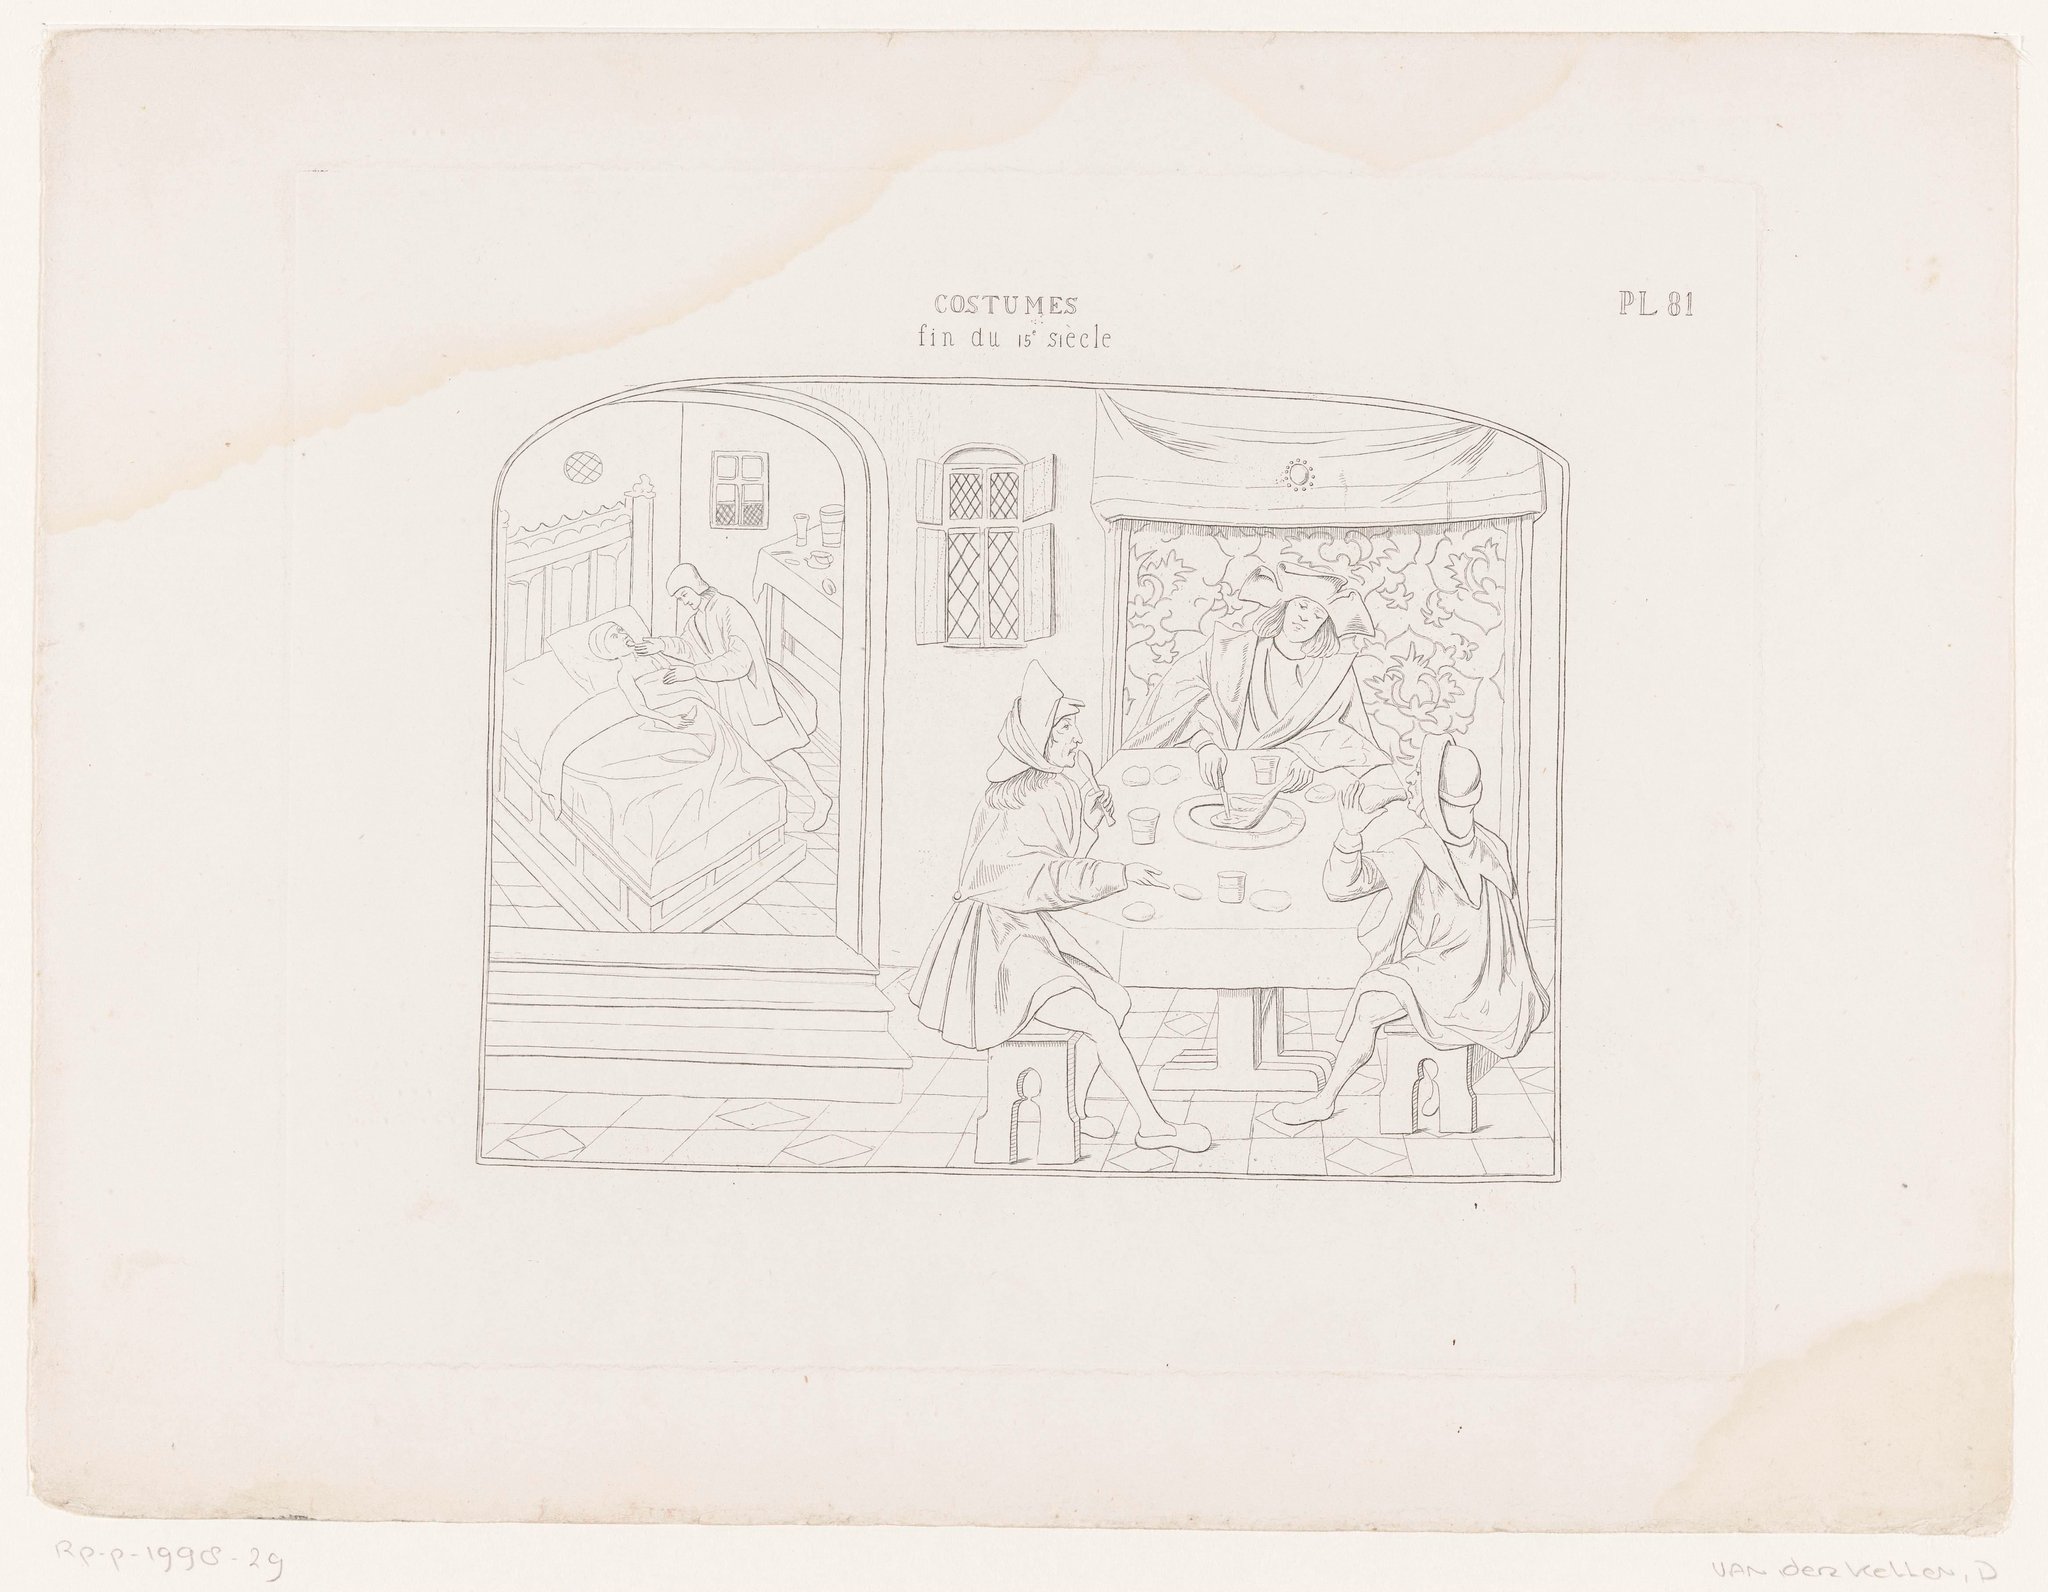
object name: print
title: Kostuums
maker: david van der kellen (1804-1879)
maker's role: die cutter, draughtsman, print maker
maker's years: 1804-1879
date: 1865-1878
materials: paper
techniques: etching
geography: netherlands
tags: clothes, costume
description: Laat vijftiende-eeuwse kostuums: Drie mannen etend aan tafel, linksachter een doorkijk naar een zieke in bed.